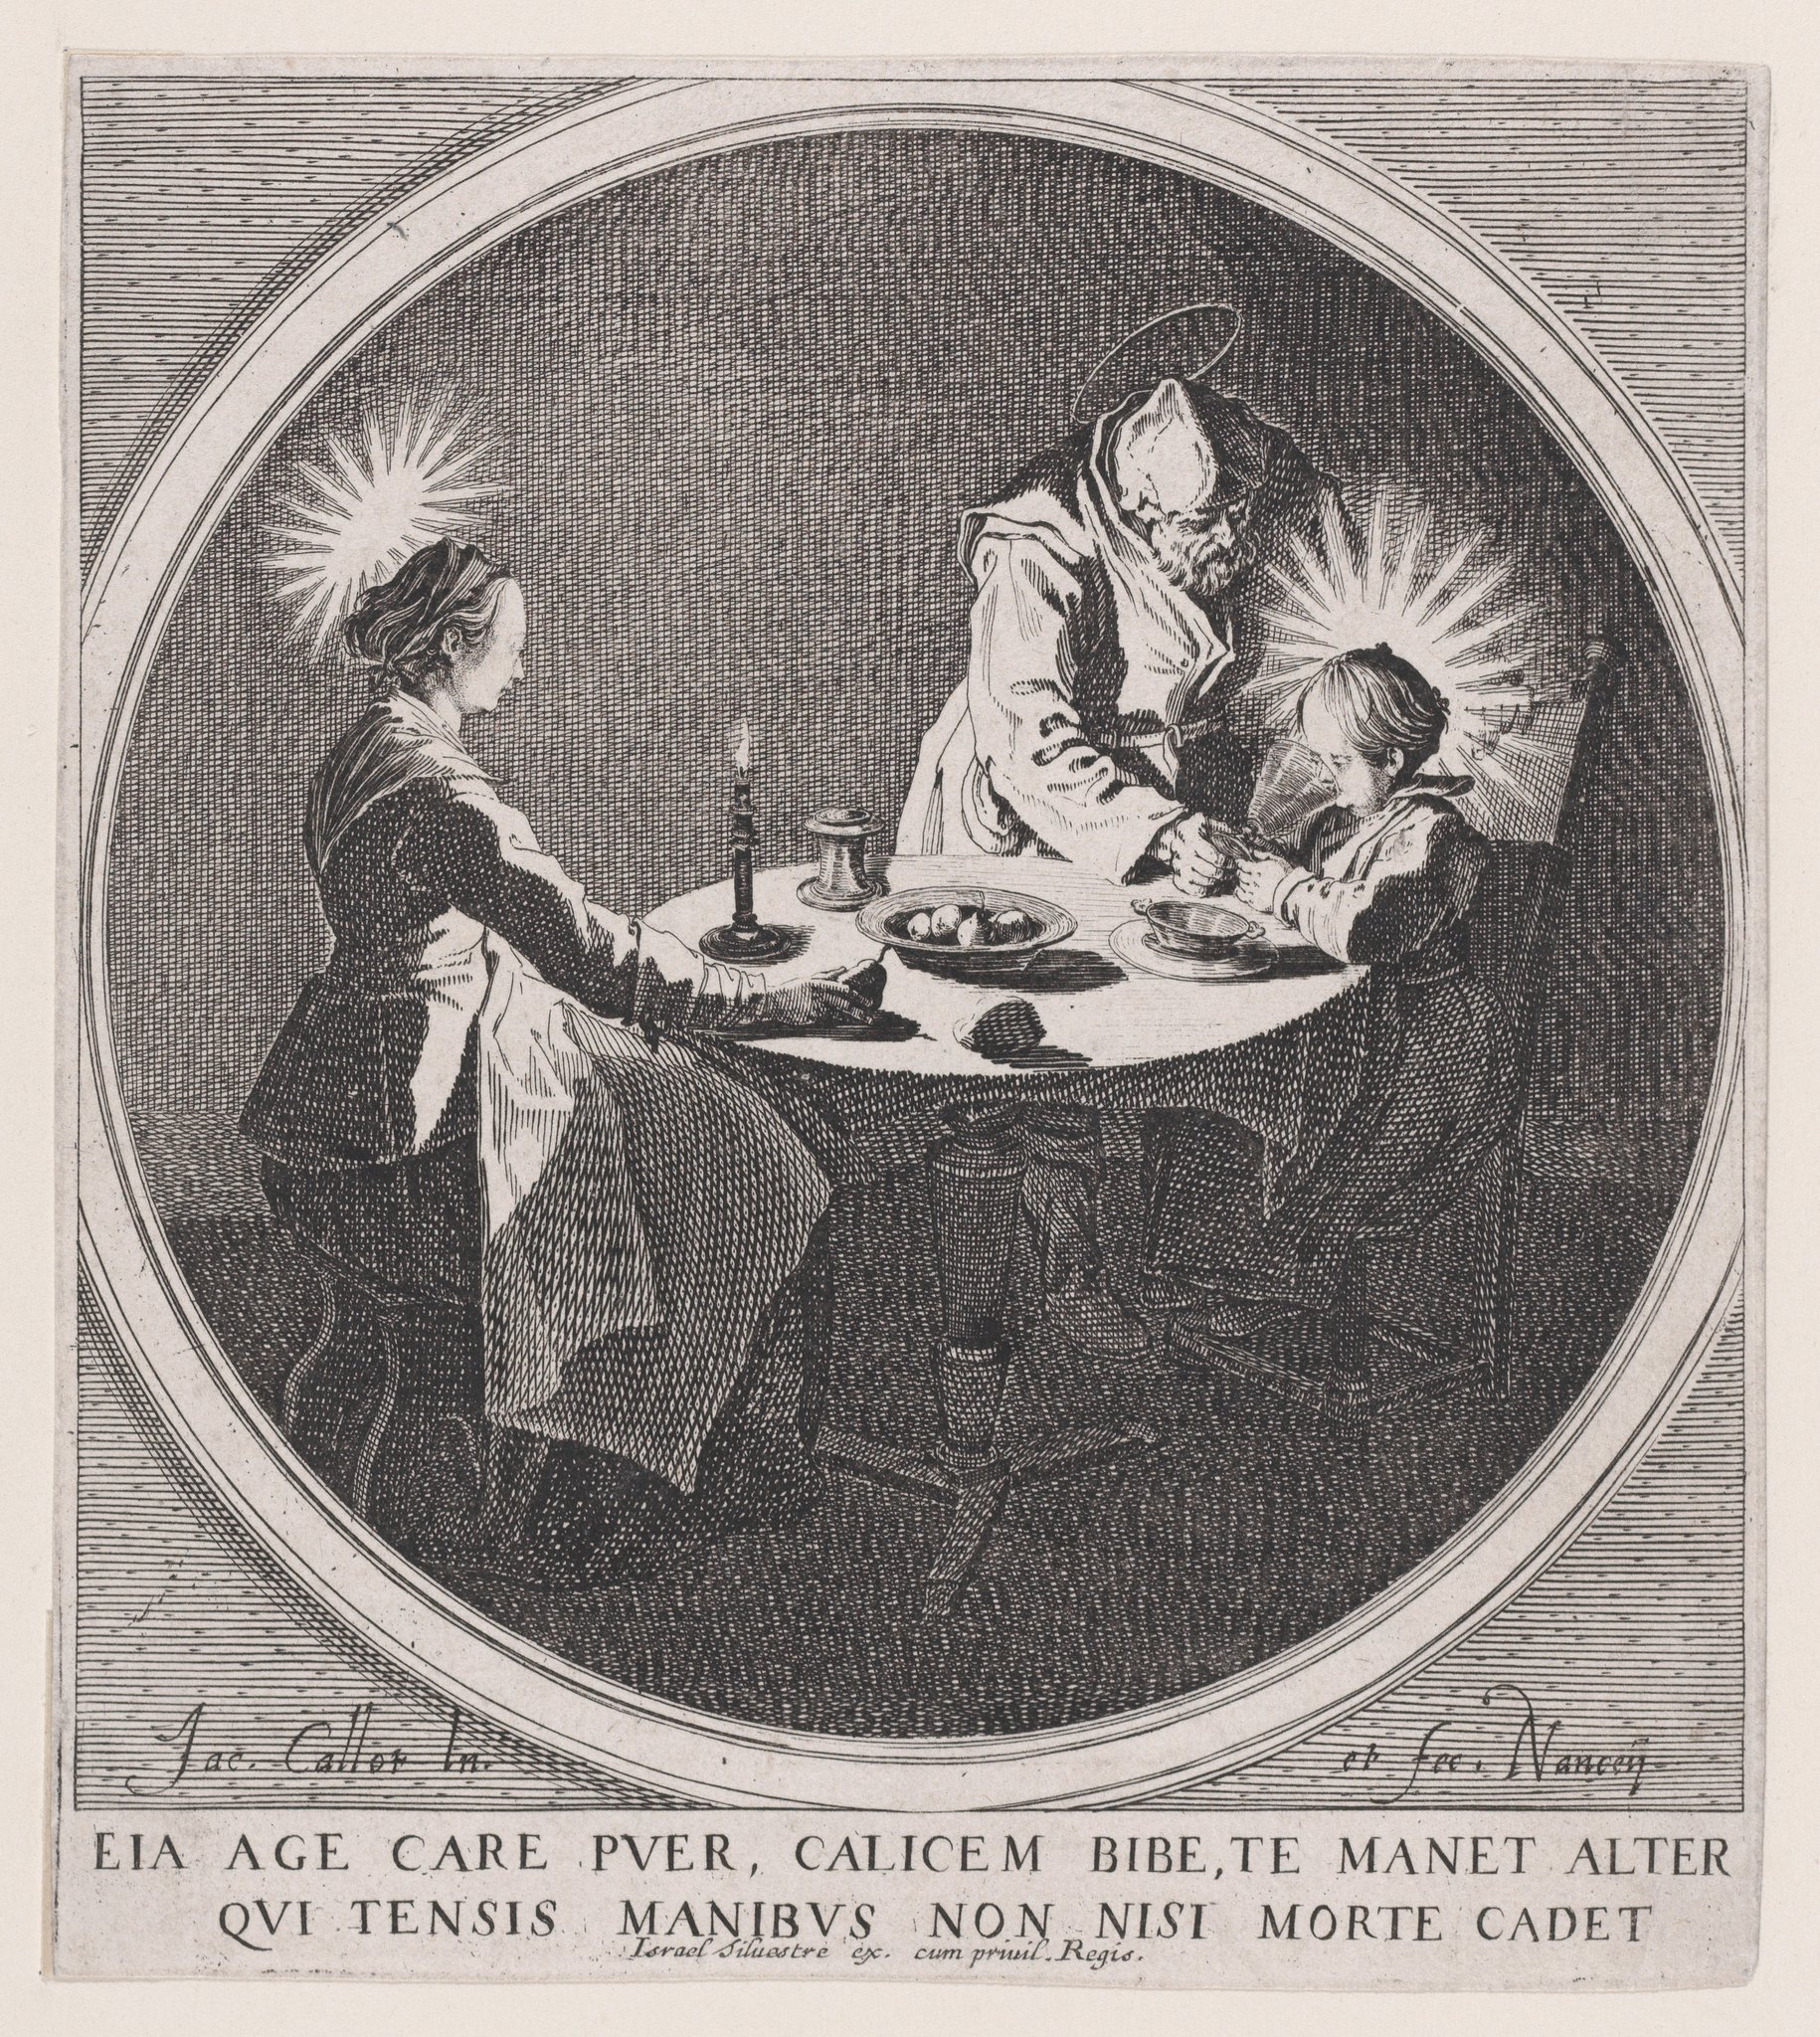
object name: print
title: Le Benedicite, estampe appelée aussi La Sainte Famille a Table et St. Joseph Faisant Boire L'Enfant Jésus (The Grace, also called The Holy Family at the Table and St. Joseph Giving the Christ Child a Drink)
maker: jacques callot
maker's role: artist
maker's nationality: french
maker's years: 1592-1635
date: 1601-1633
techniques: engraving, etching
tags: holy family,virgin mary,jesus,drinking,eating,joseph